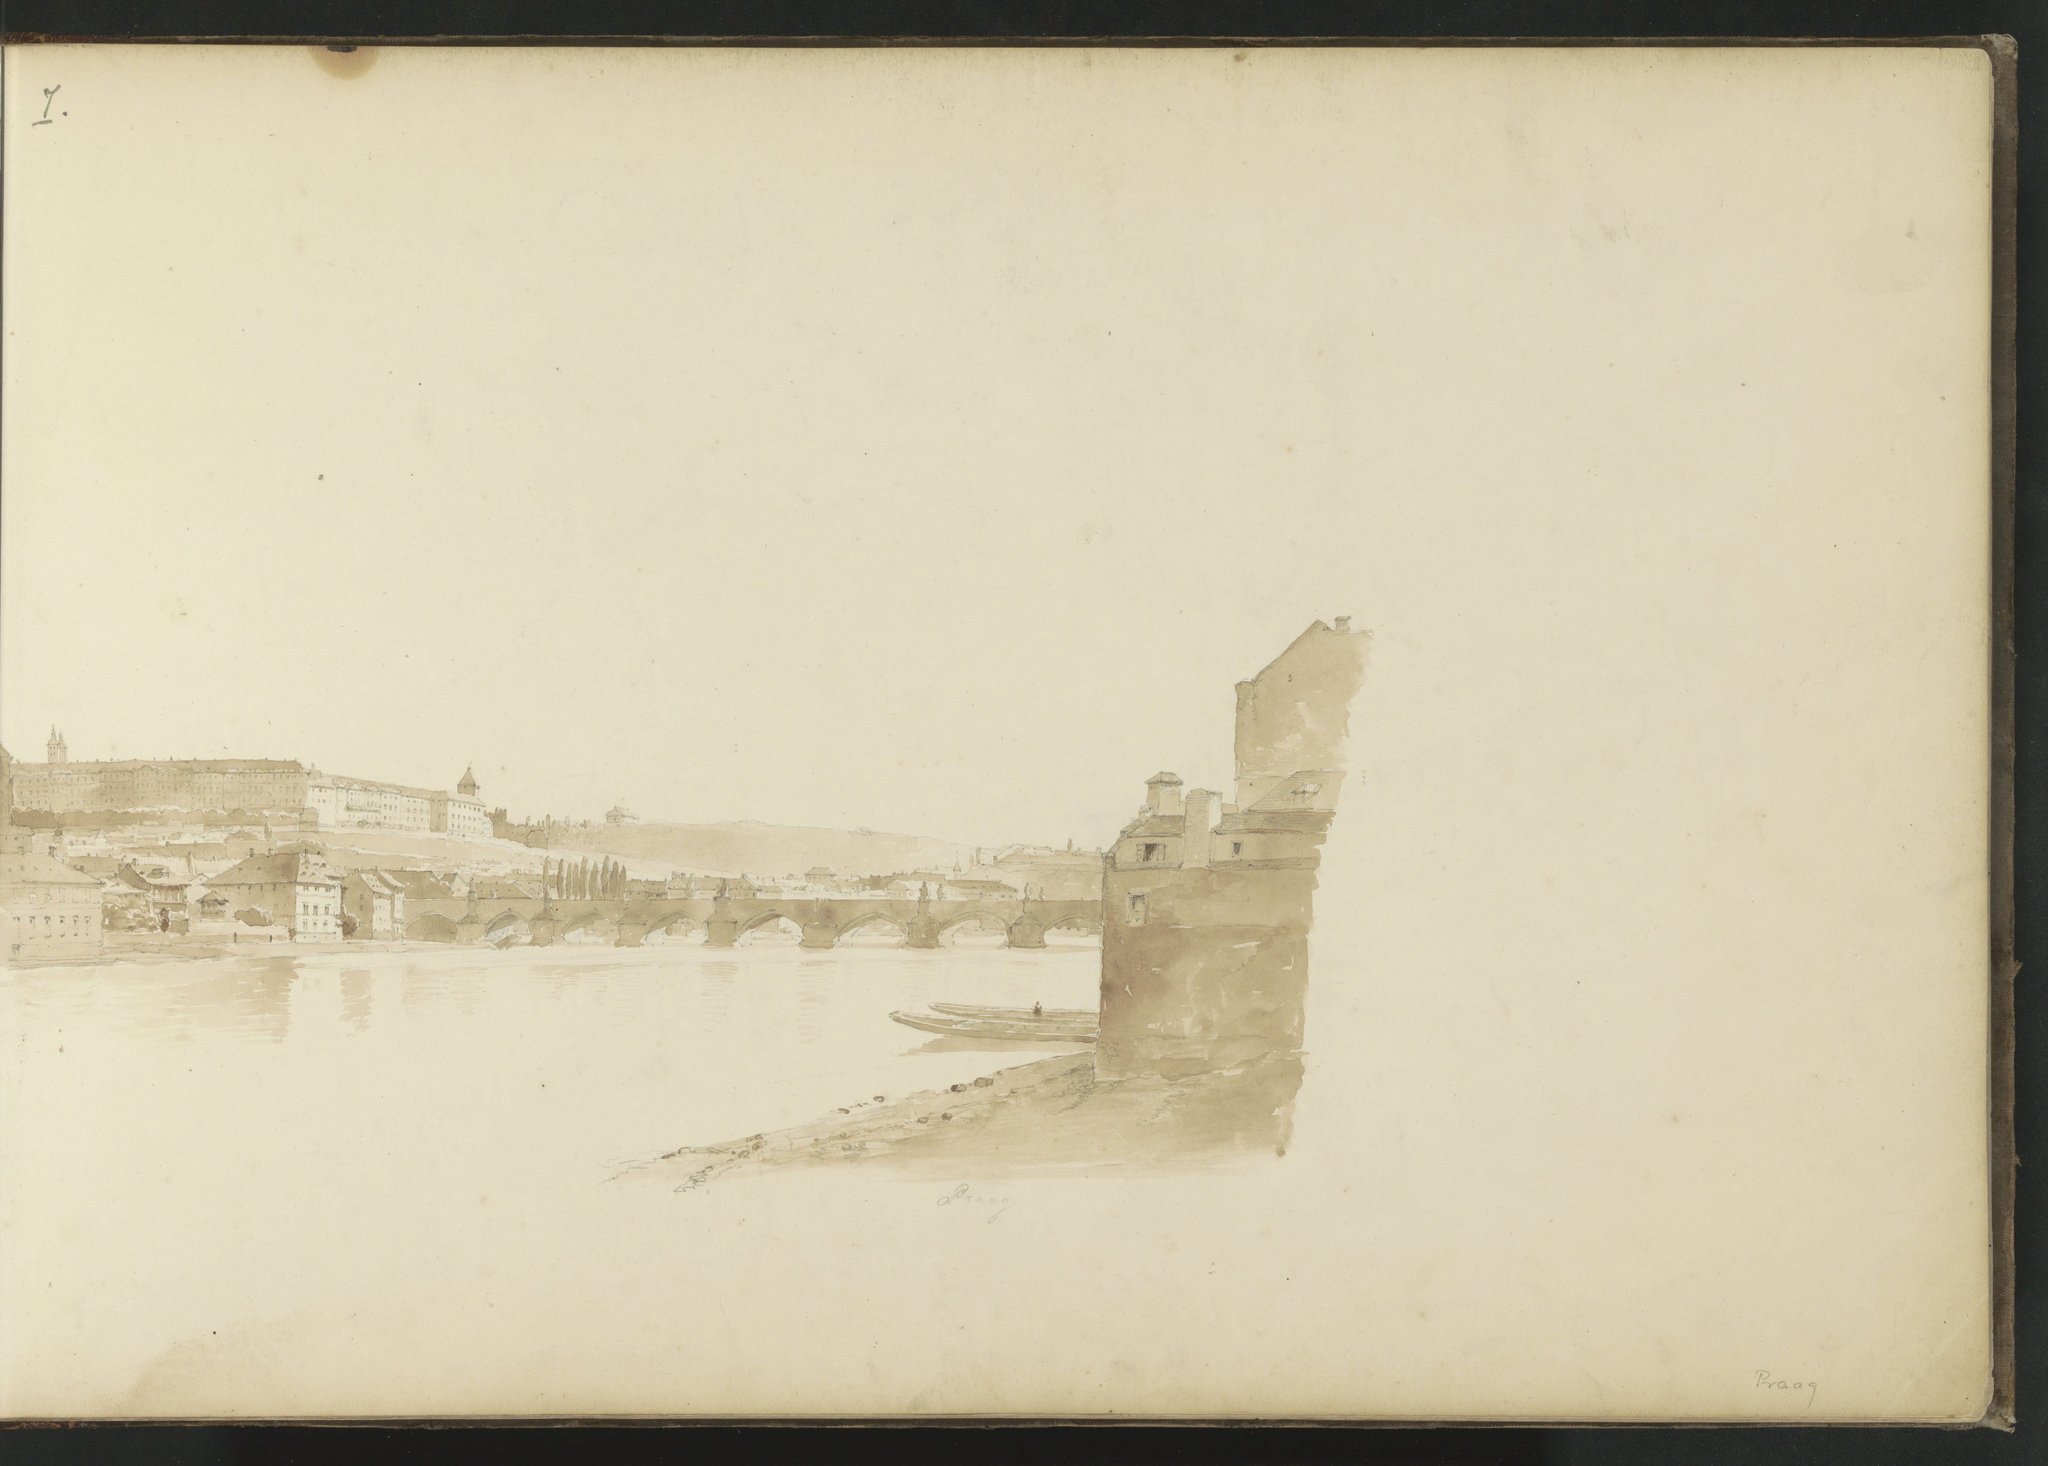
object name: sketchbook leaf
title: Gezicht op Praag met de Karelsbrug over de Moldau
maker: kasparus karsen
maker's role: draughtsman, painter, print maker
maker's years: 1810-1896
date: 1820-1896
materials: paper, pencil, watercolor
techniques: brush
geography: prague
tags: city-view, and landscape with man-made constructions, river, bridge, prague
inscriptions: annotation: ‘Praag Praag’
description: Blad 7 recto uit een schetsboek met 68 bladen.